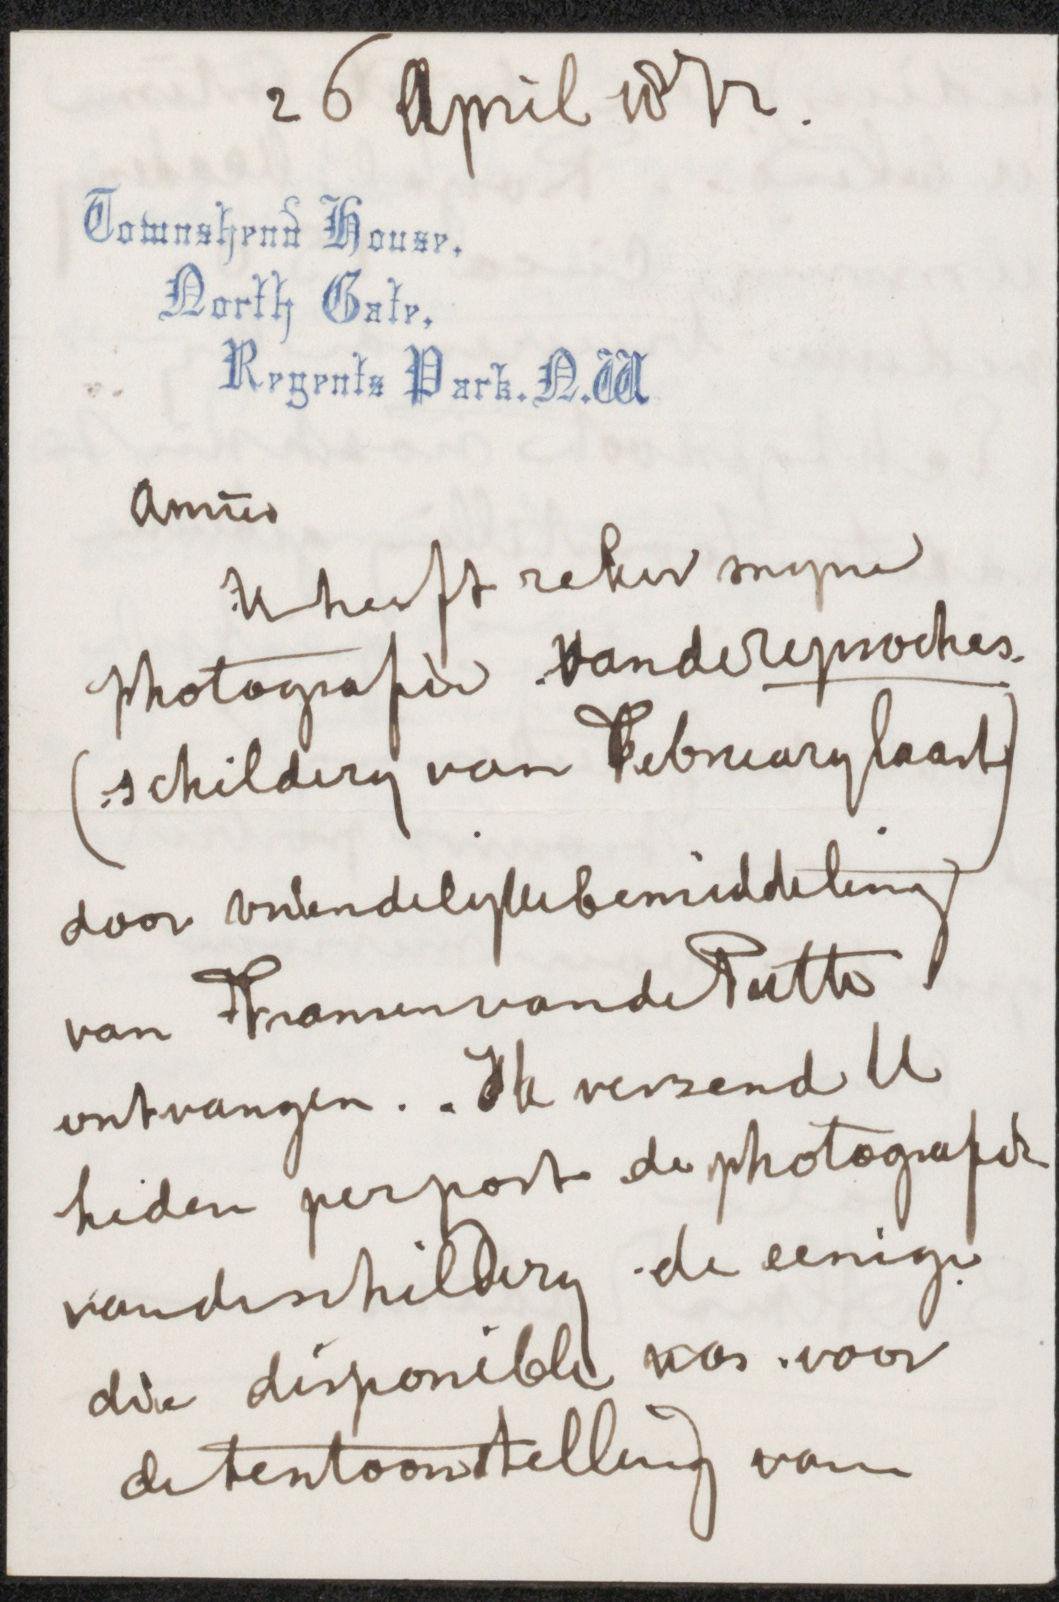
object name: letter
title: Brief aan Carel Vosmaer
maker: lourens alma tadema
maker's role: draughtsman, print maker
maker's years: 1836-1912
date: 1872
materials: ink, paper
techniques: pen, printing, writing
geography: london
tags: carel vosmaer, fransen van de putte, drawing, photography, cinematography, painting (including book-illumination, miniature-painting), exhibition ~ art, historical persons (portraits and scenes from the life), the hague, paris